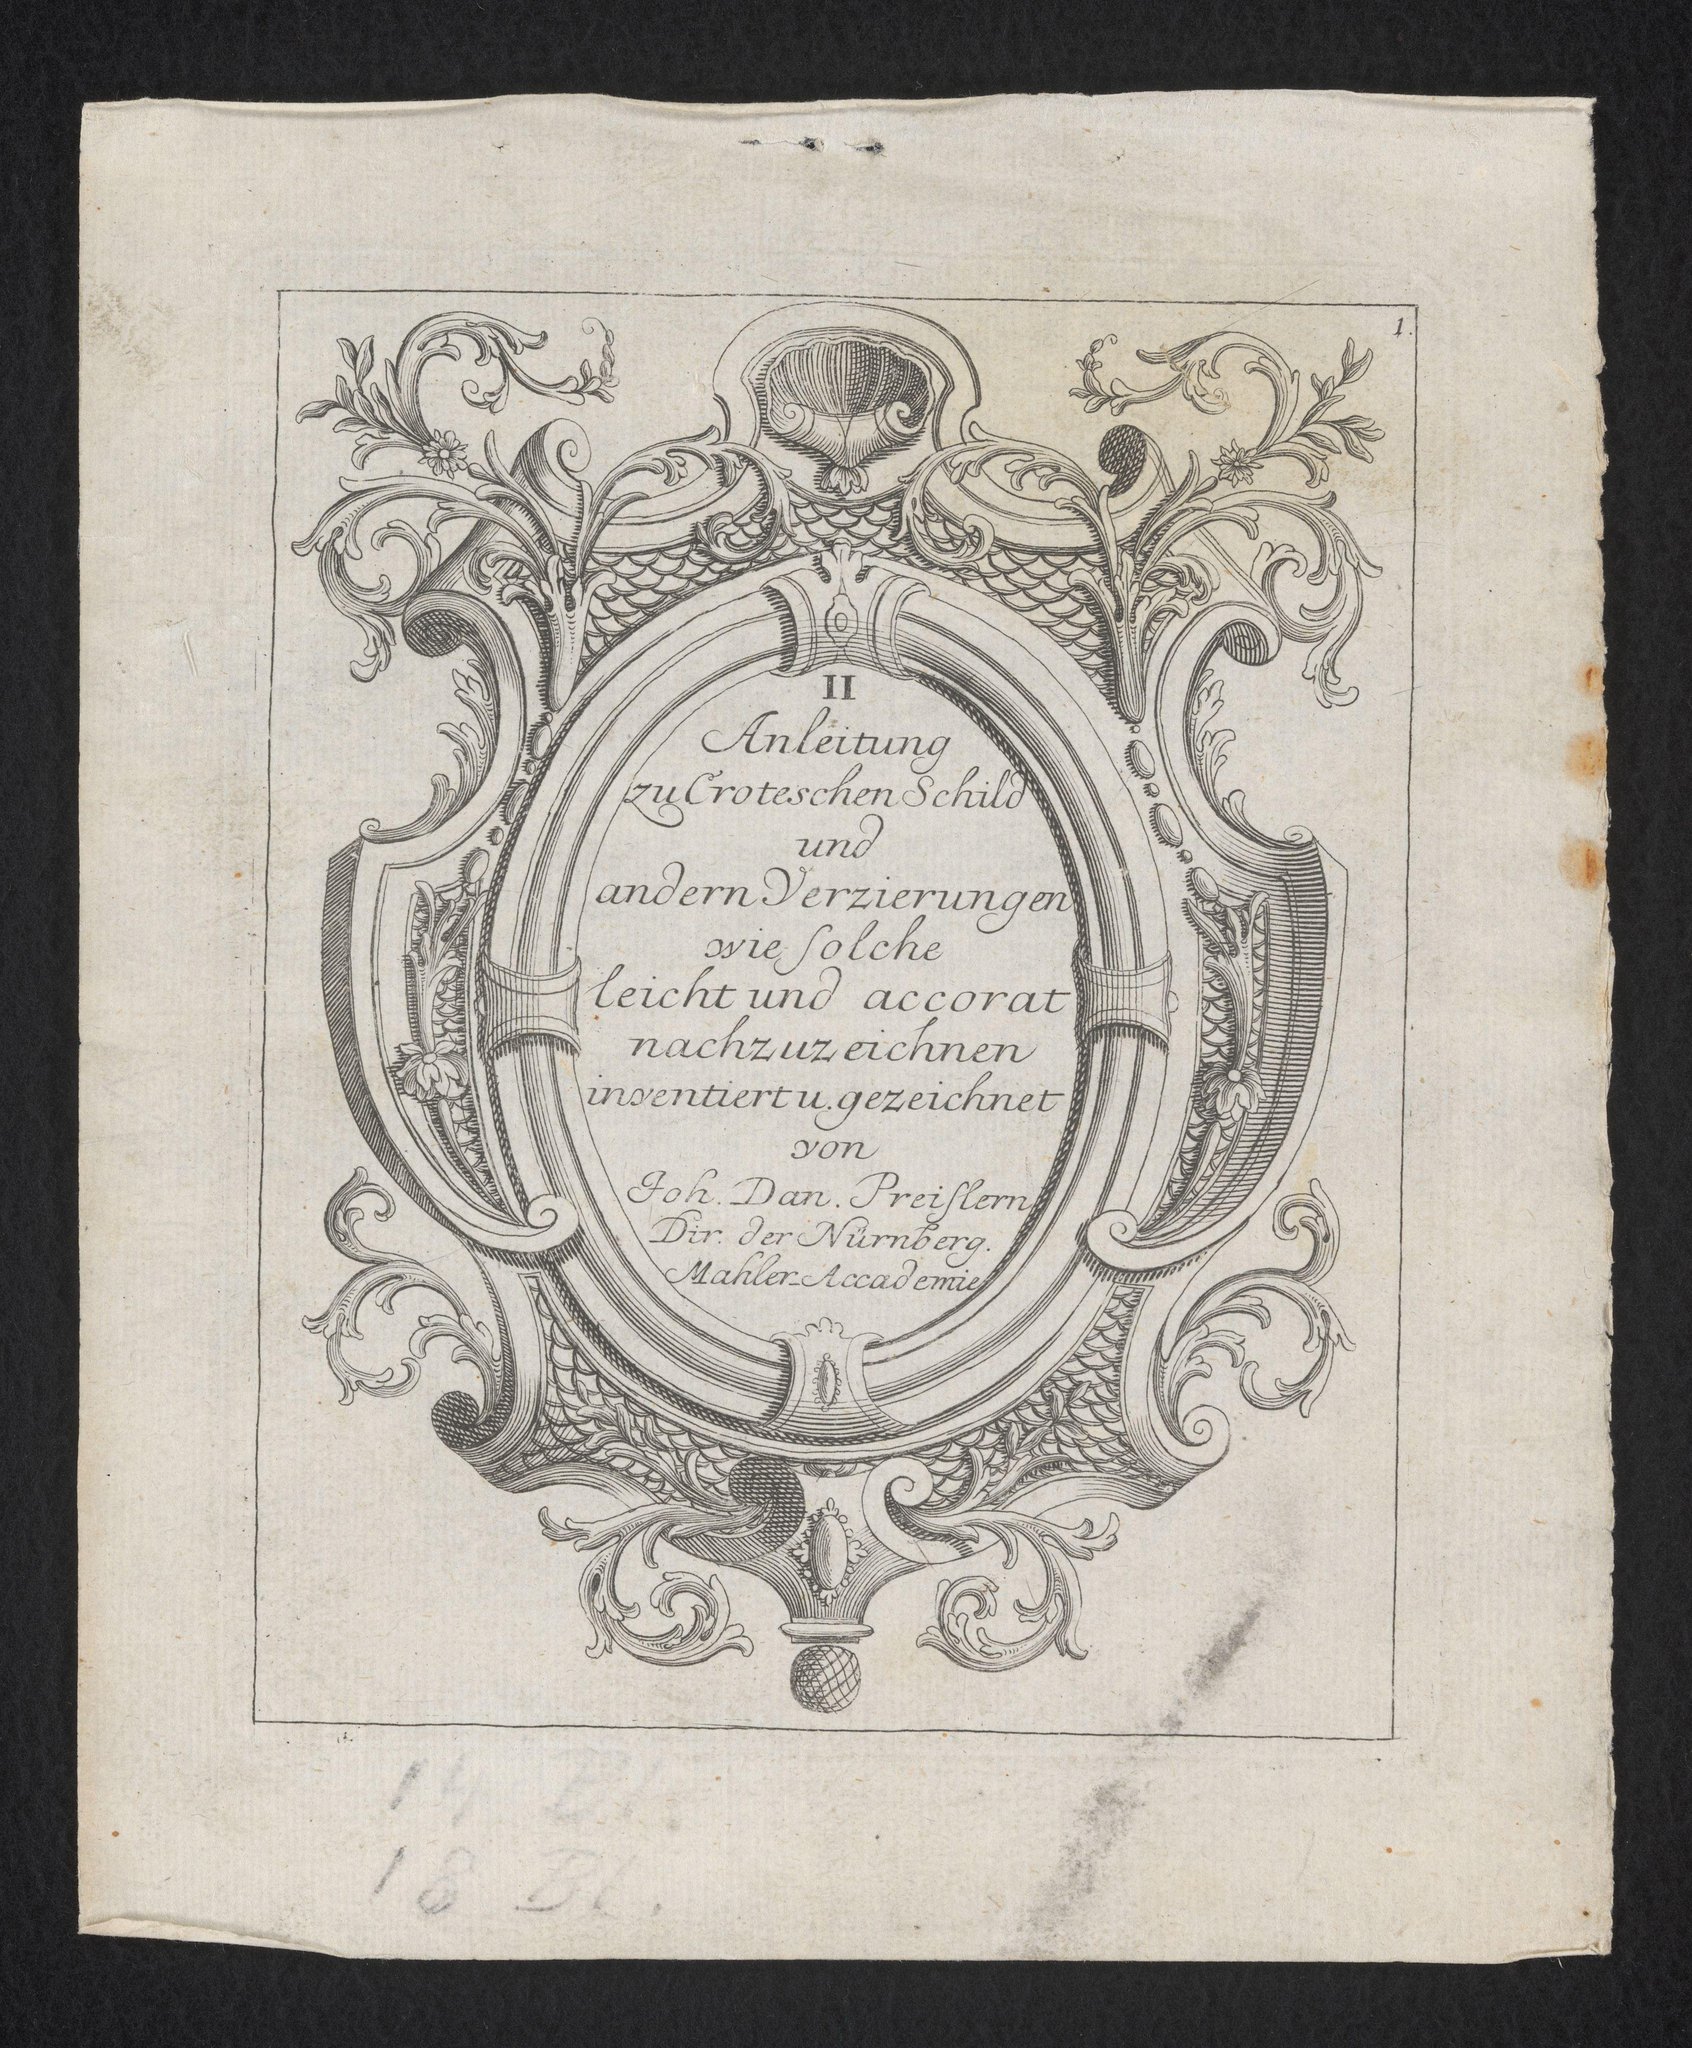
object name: print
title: II Anleitung zu Groteschen Schild und andern Verzierungen (...)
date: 1704-1737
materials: paper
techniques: engraving, etching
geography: nuremberg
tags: ornament ~ cartouche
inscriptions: collector's mark: Lugt 2760, collector's mark: Lugt 2228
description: Ovaal cartouche met rocaille ornamenten en bloem- en bladmotieven waarin de serietitel.